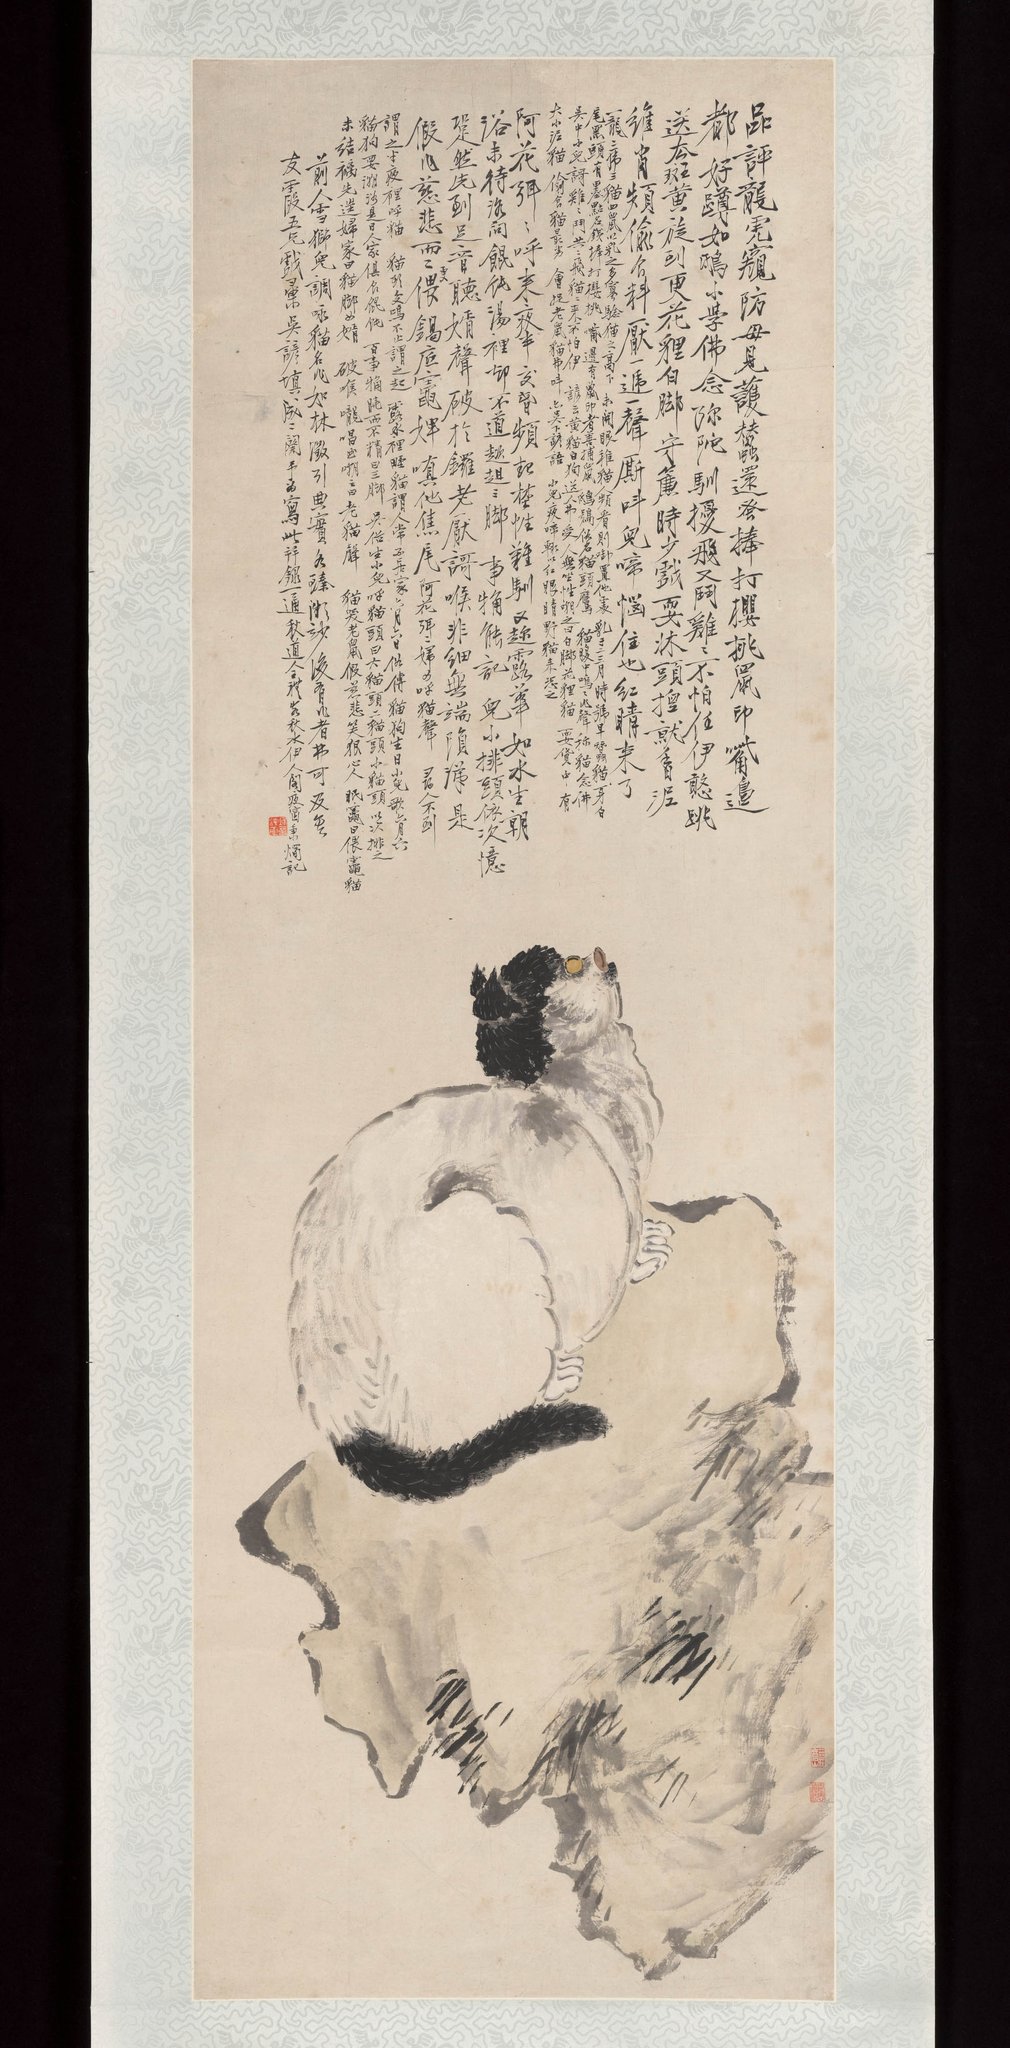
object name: hanging scroll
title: Cat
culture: chinese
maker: wang li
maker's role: artist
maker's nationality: chinese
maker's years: 1813-1879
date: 1813-1879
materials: ink, paper